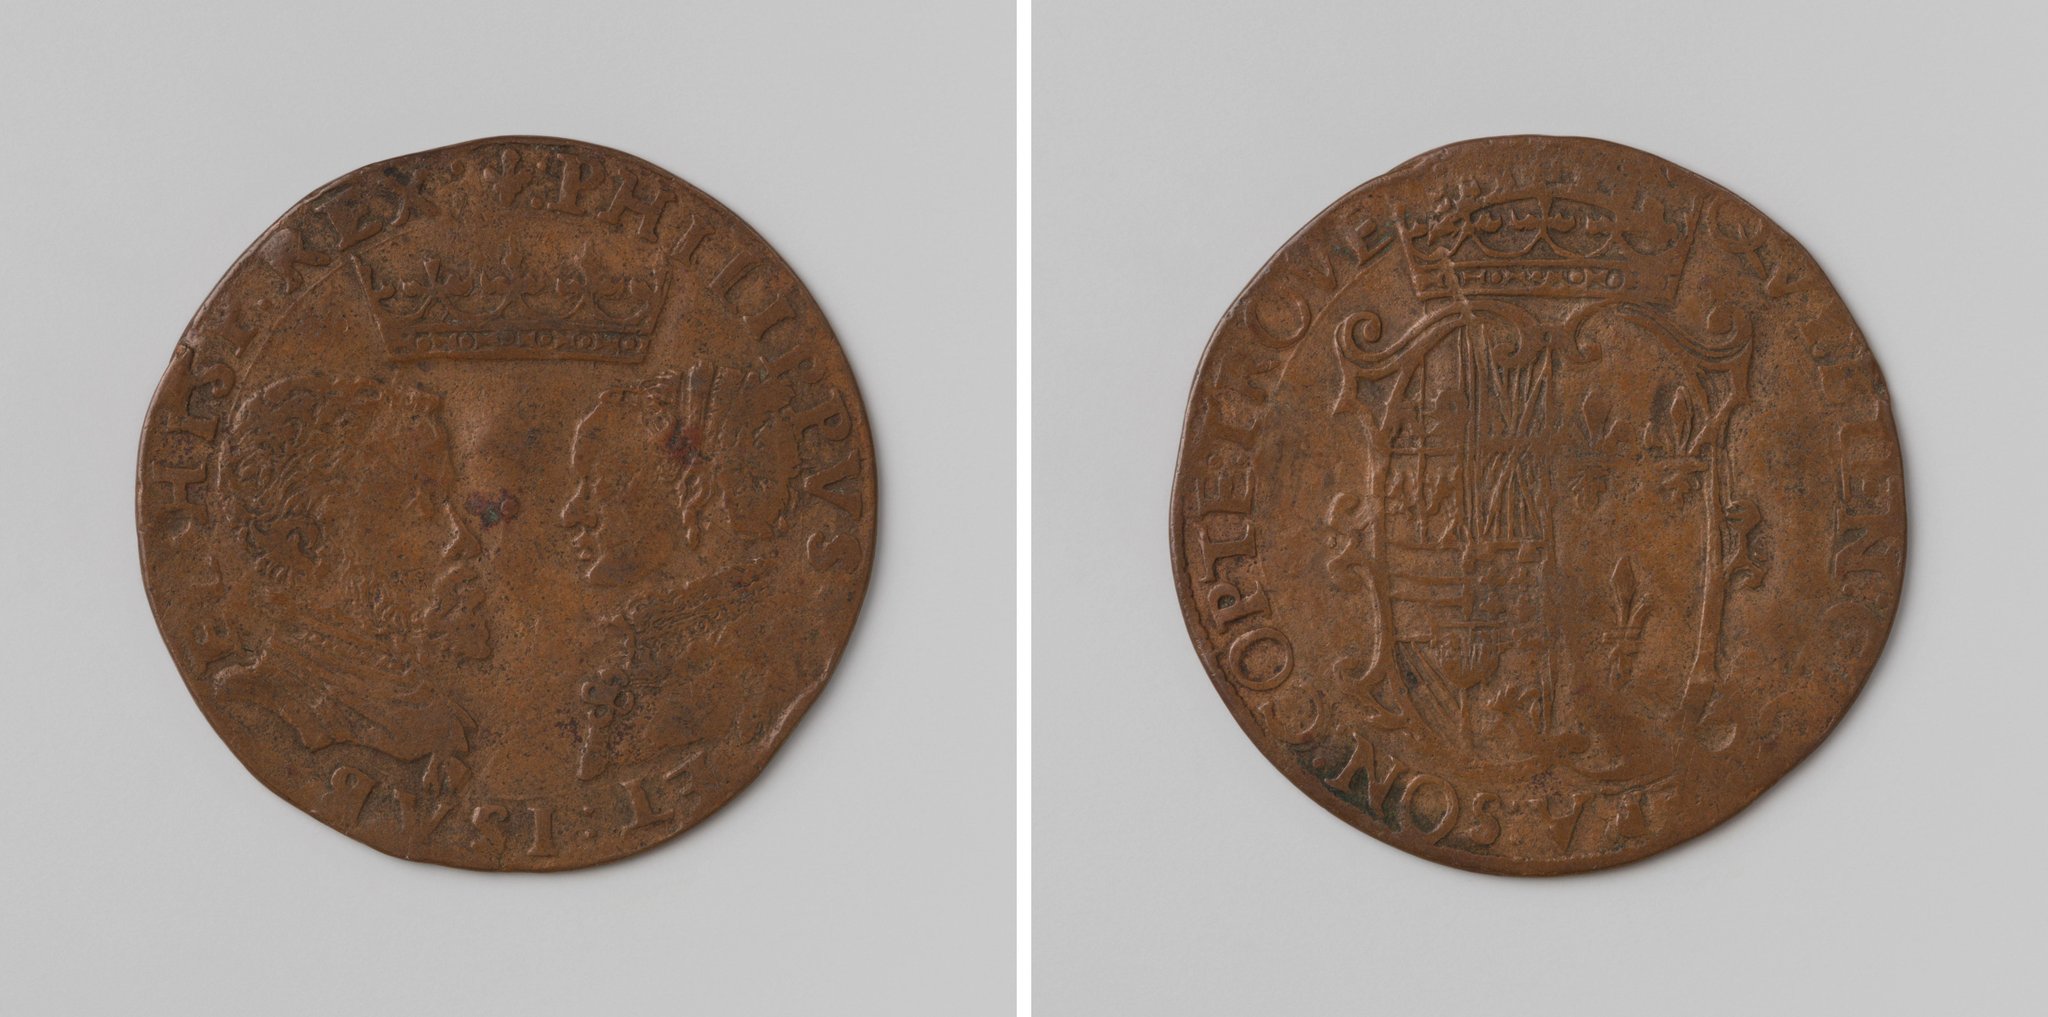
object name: jeton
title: Huwelijk van Filips II, koning van Spanje en Elisabeth van Valois, overeenkomstig de voorwaarden van de vrede van Le Cateau-Cambresis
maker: Anonymous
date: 1559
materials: copper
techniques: striking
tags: philip ii of spain, paris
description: Koperen penning. Voorzijde: naar elkaar gewende borststukken van man en vrouw onder kroon binnen omschrift. Keerzijde: gekroond wapenschild in cartouche binnen omschrift